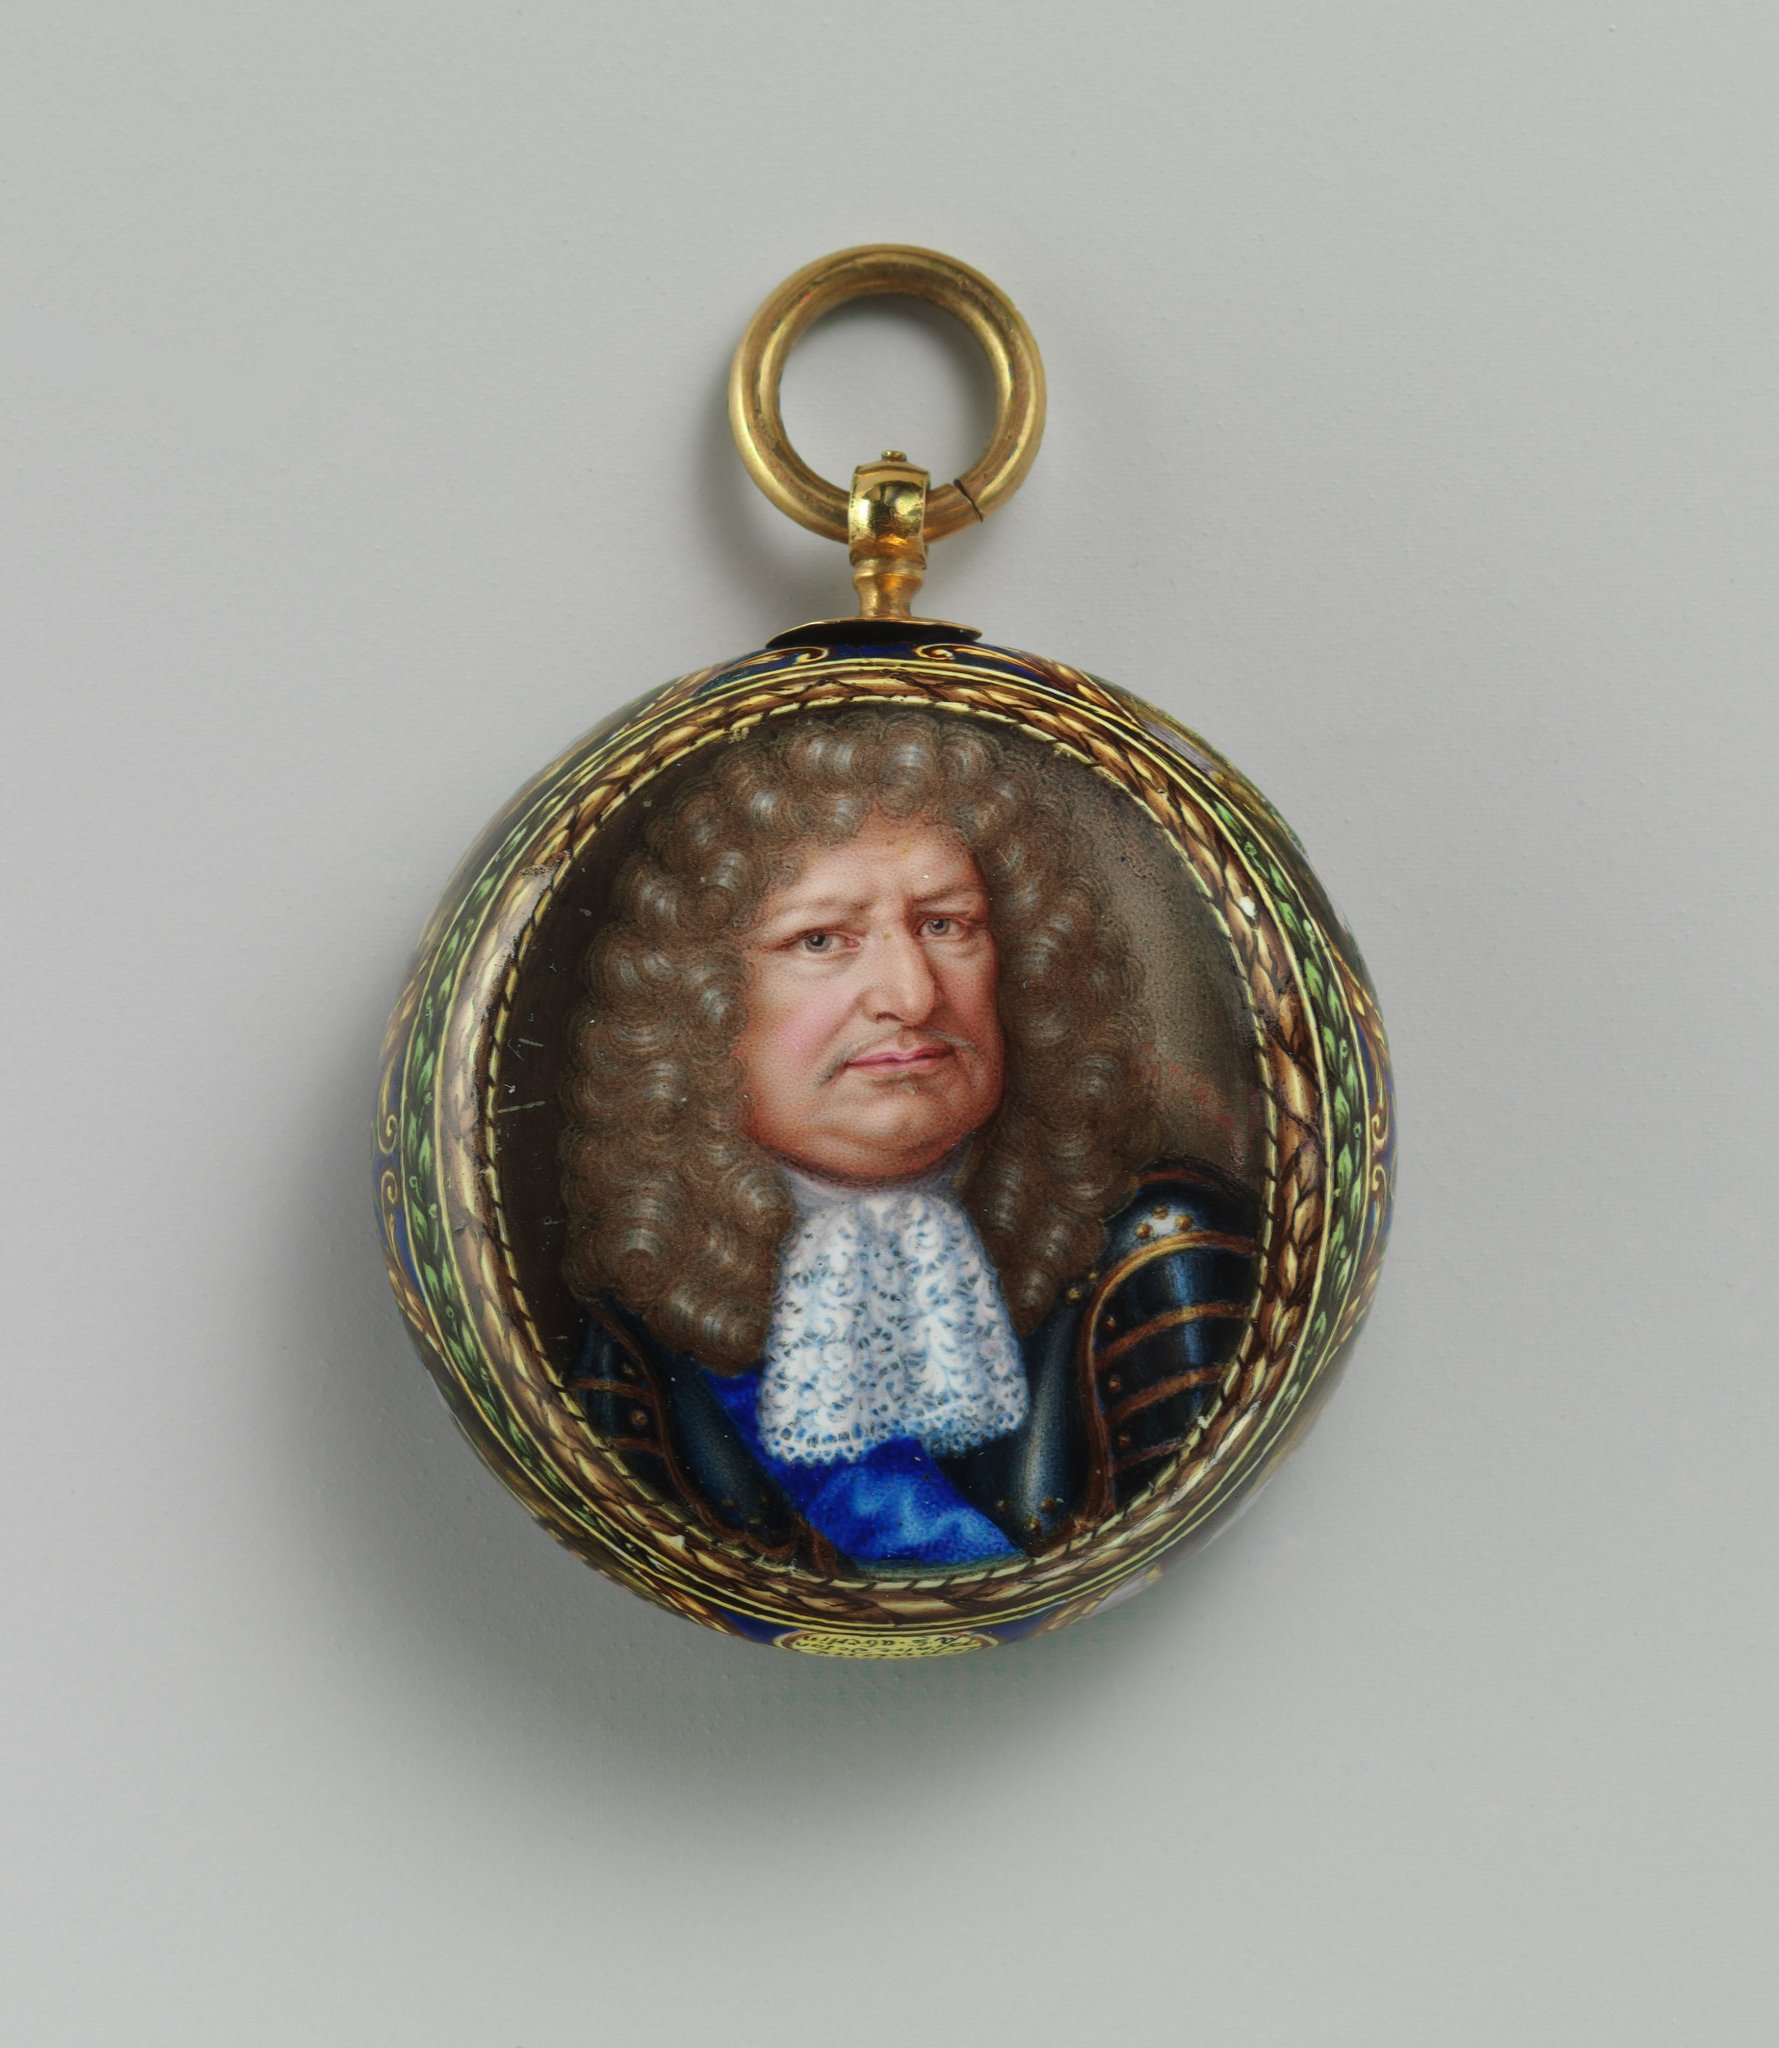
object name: watch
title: Watch with portrait of Friedrick Wilhelm, the Great Elector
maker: johann g. racine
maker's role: maker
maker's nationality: swiss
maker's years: 1748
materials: brass, enamel, gold, steel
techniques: painting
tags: men,portraits